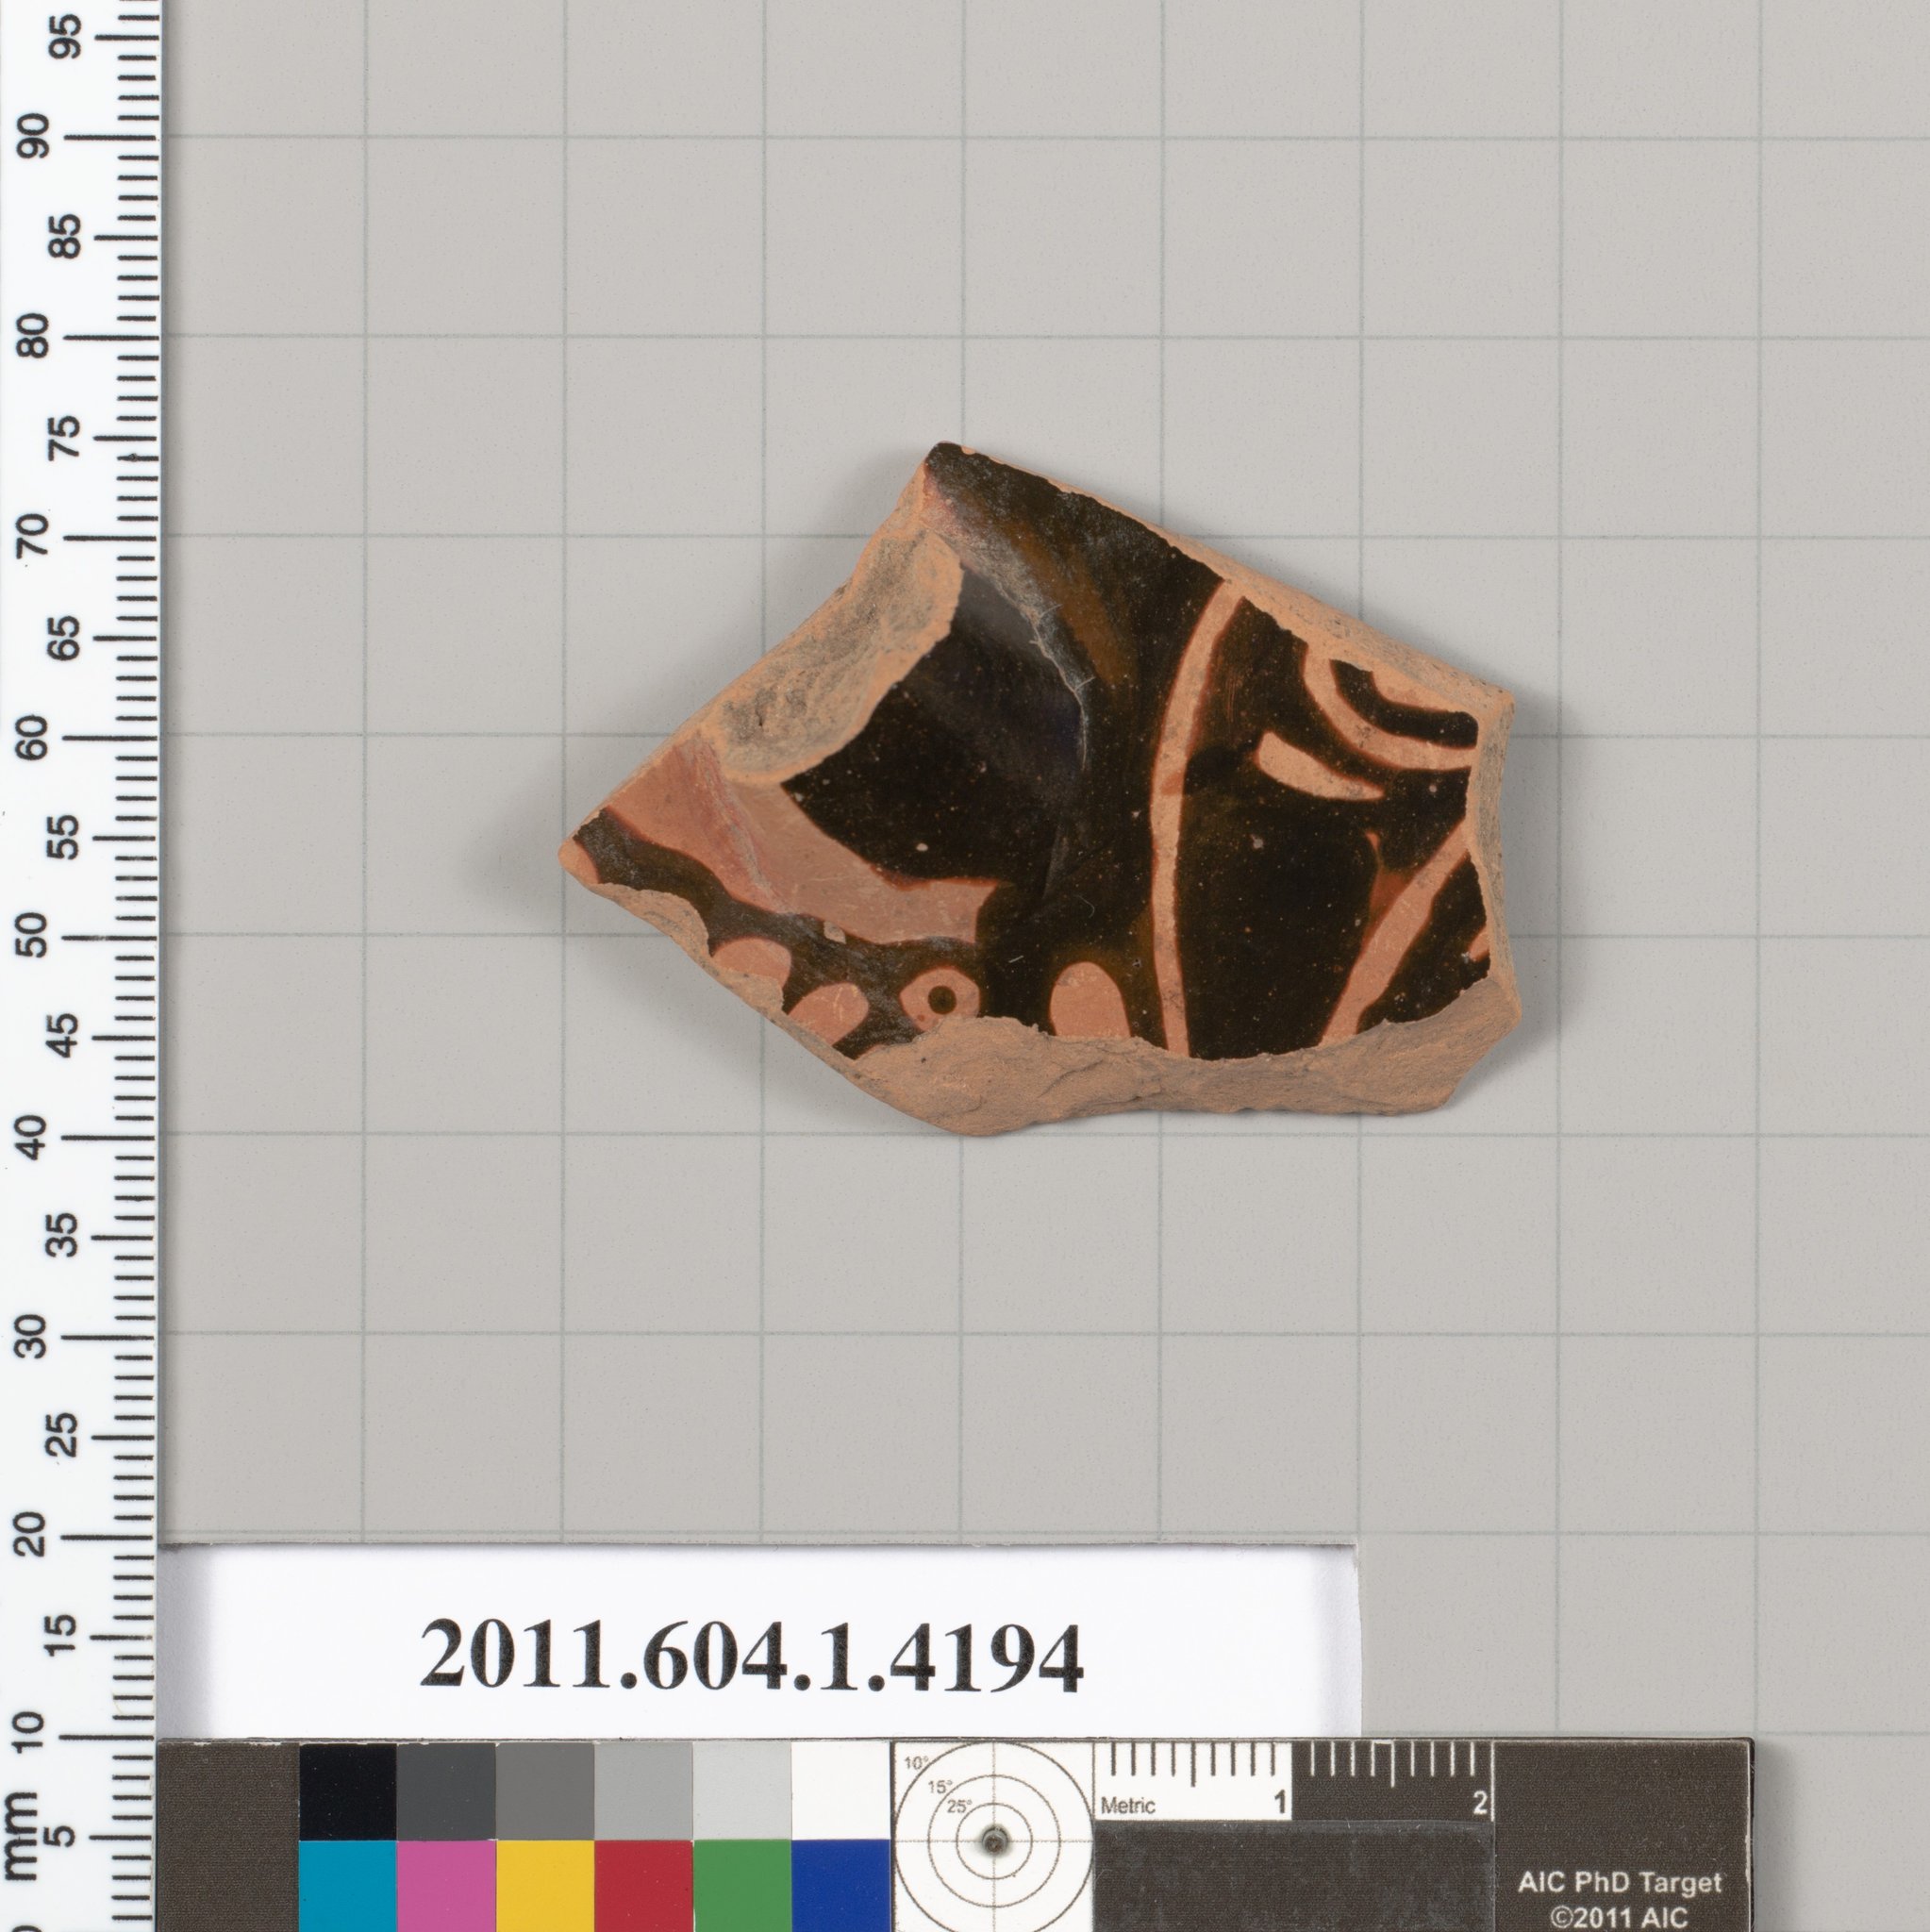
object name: kylix fragment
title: Terracotta fragment of a kylix (drinking cup)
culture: greek, attic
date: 475-451 BCE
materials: terracotta